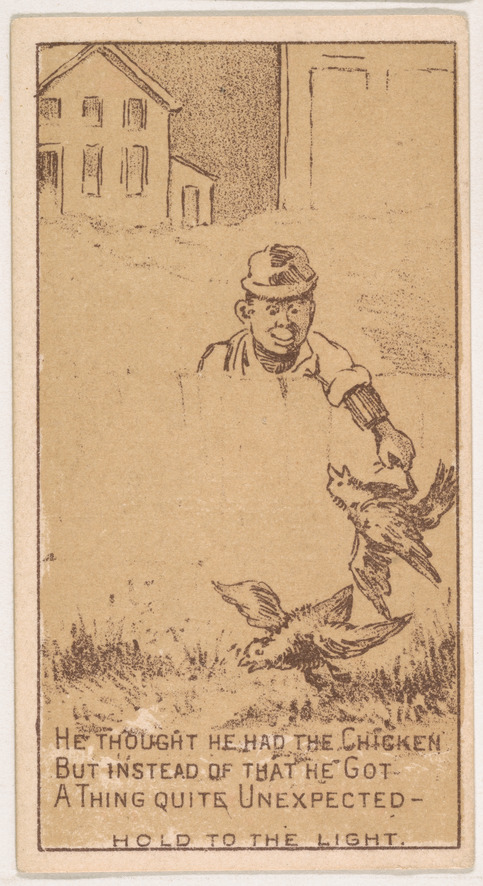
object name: print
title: He Thought He Had the Chicken..., from the Magic Changing Cards series (N223) issued by Kinney Tobacco Company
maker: kinney brothers tobacco company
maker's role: publisher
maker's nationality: american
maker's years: 1869-2011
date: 1889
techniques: color lithograph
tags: chickens,men